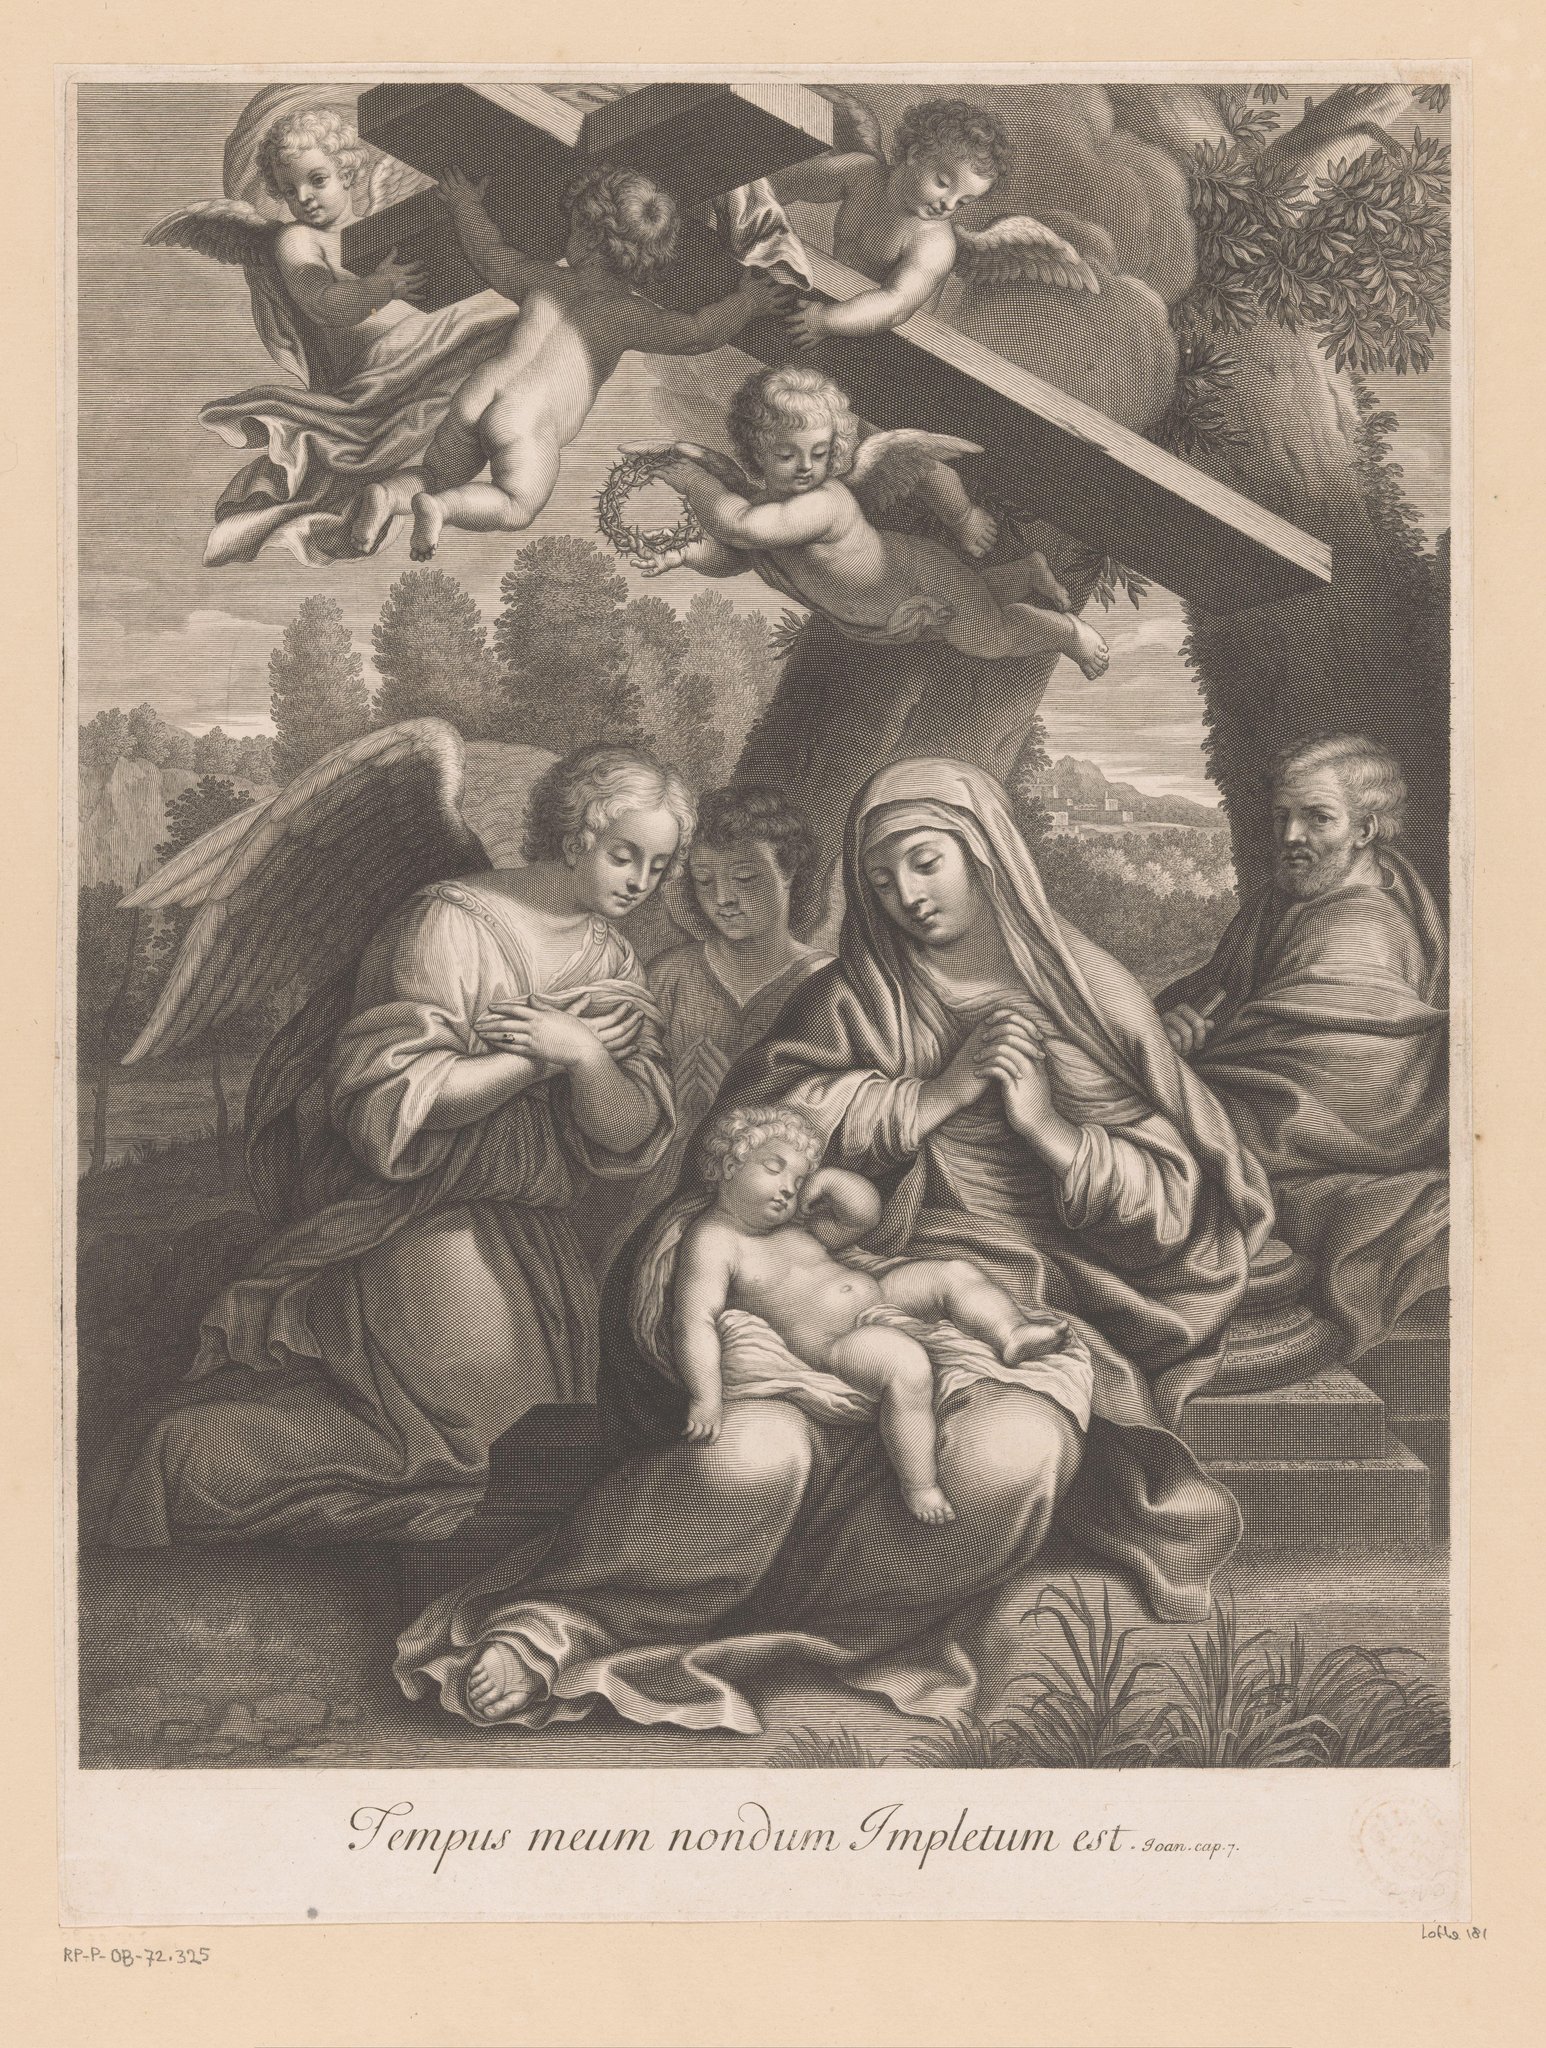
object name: print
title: Heilige Familie met slapend kind aanbeden door engelen, boven hen dragen putti het kruis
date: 1632-1693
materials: paper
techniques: engraving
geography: paris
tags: angels in adoration, holy family, and derived representations (+ angel(s))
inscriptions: collector's mark: Lugt 240